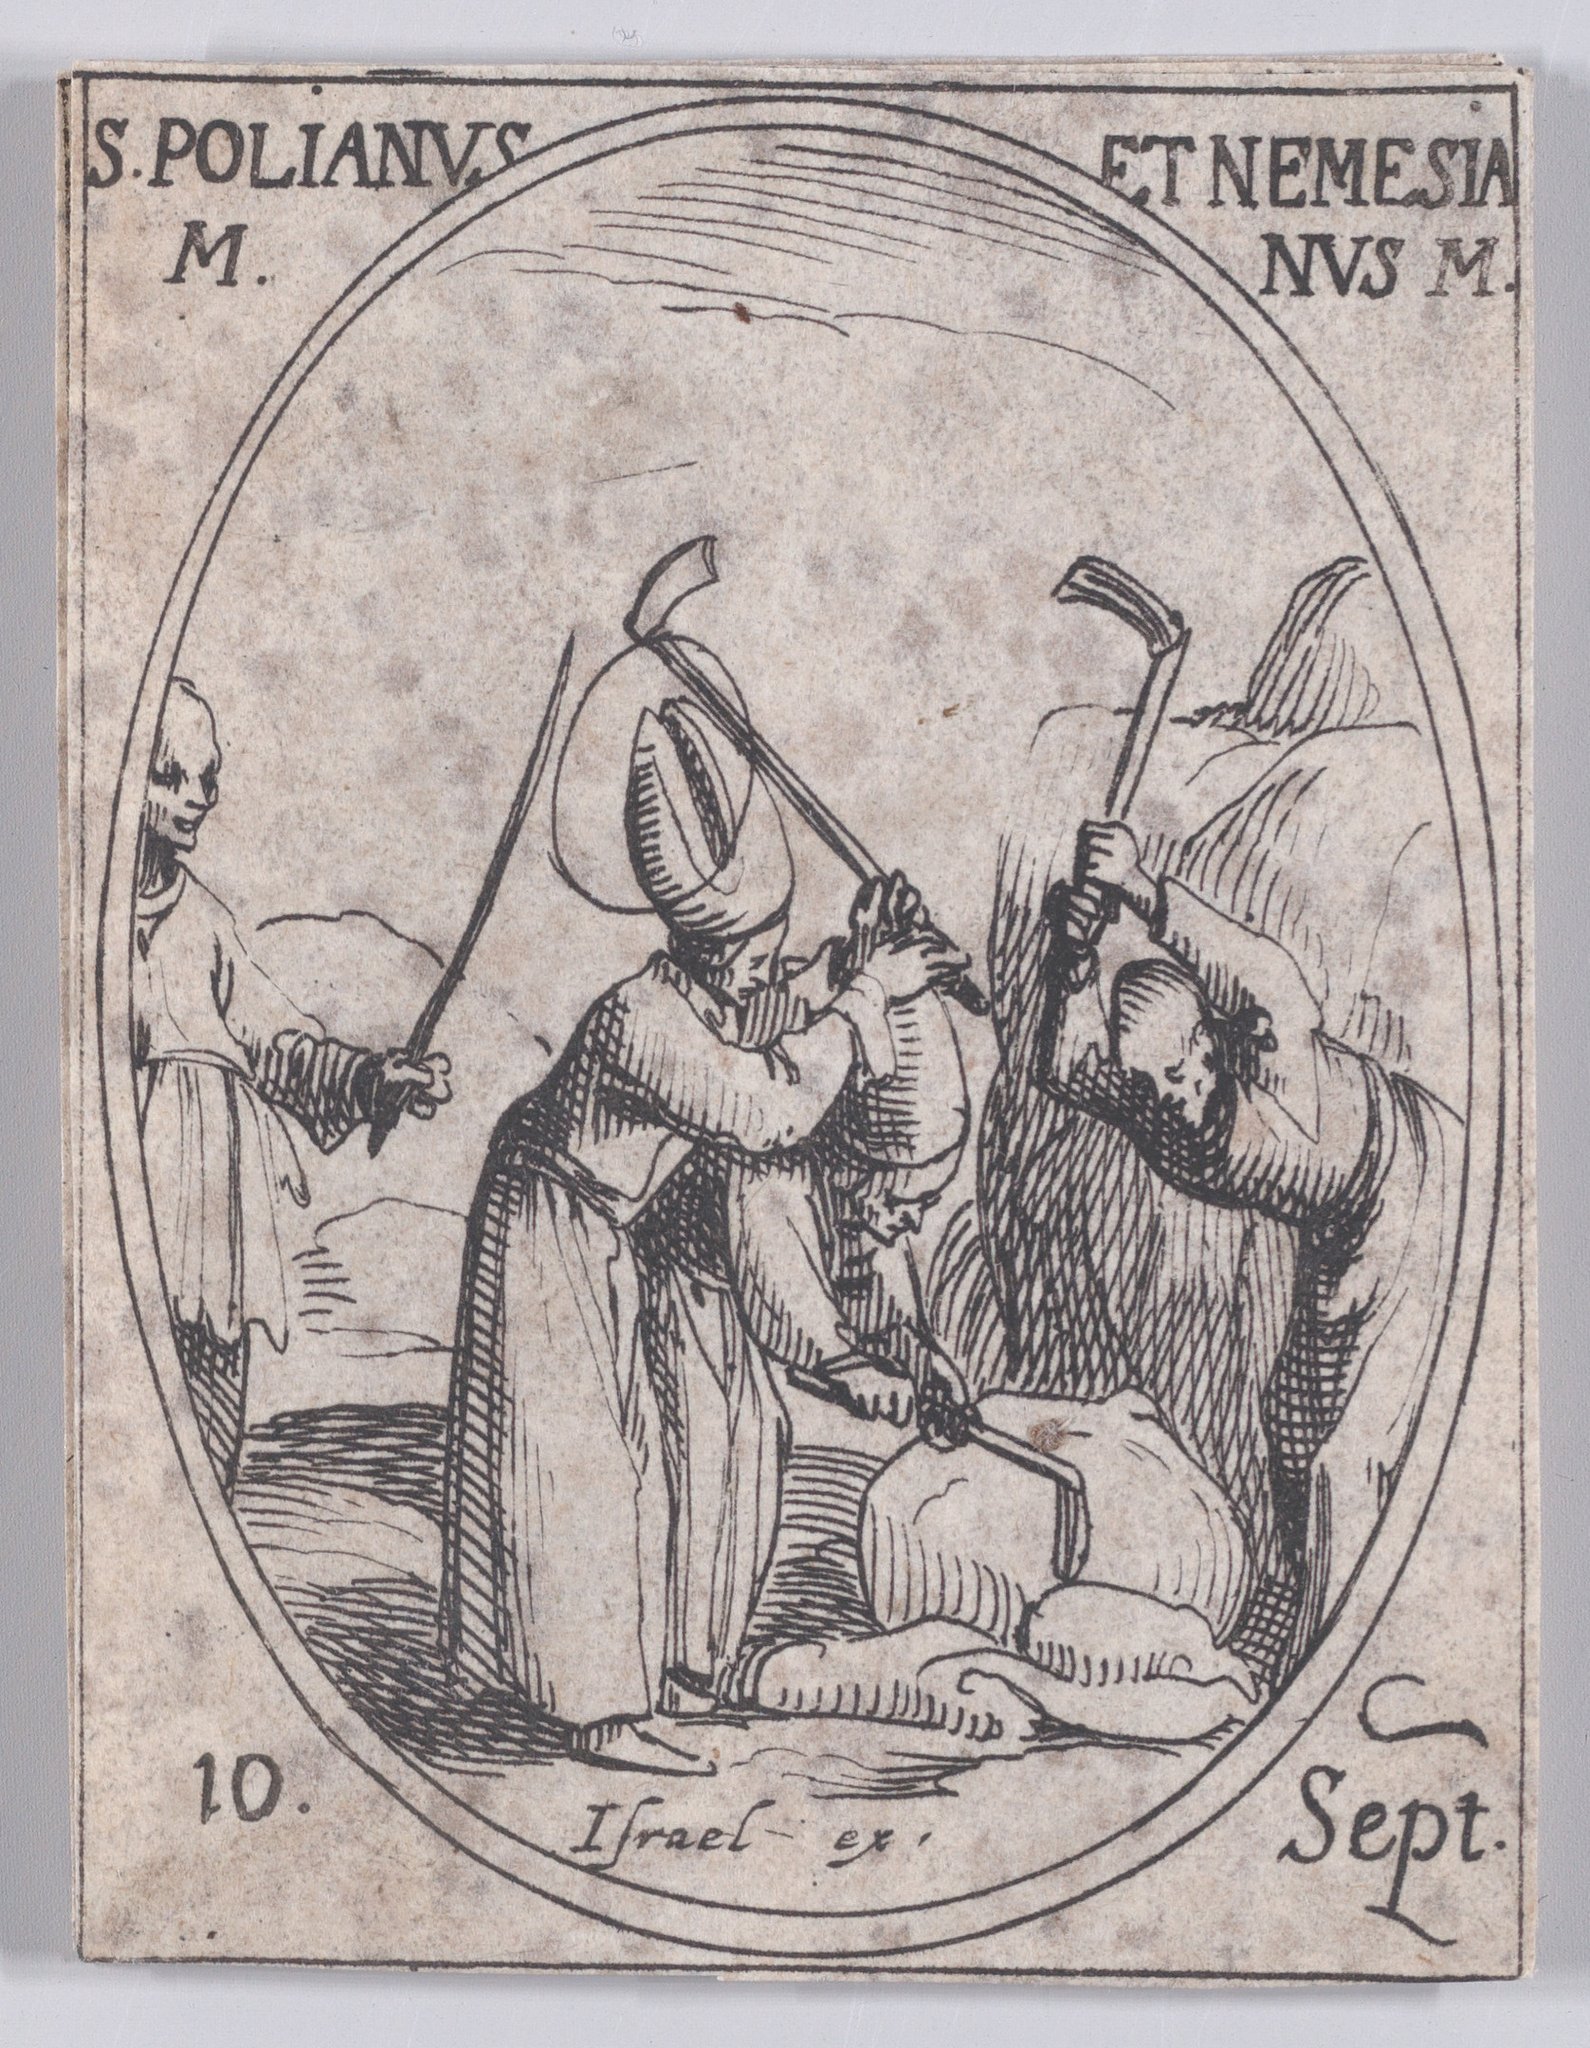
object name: print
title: S. Polien et S. Nemesien (St. Polianus and St. Nemesianus), September 10th, from "Les Images De Tous Les Saincts et Saintes de L'Année" (Images of All of the Saints and Religious Events of the Year)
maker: jacques callot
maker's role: artist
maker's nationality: french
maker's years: 1592-1635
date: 1636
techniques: etching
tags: men,saints